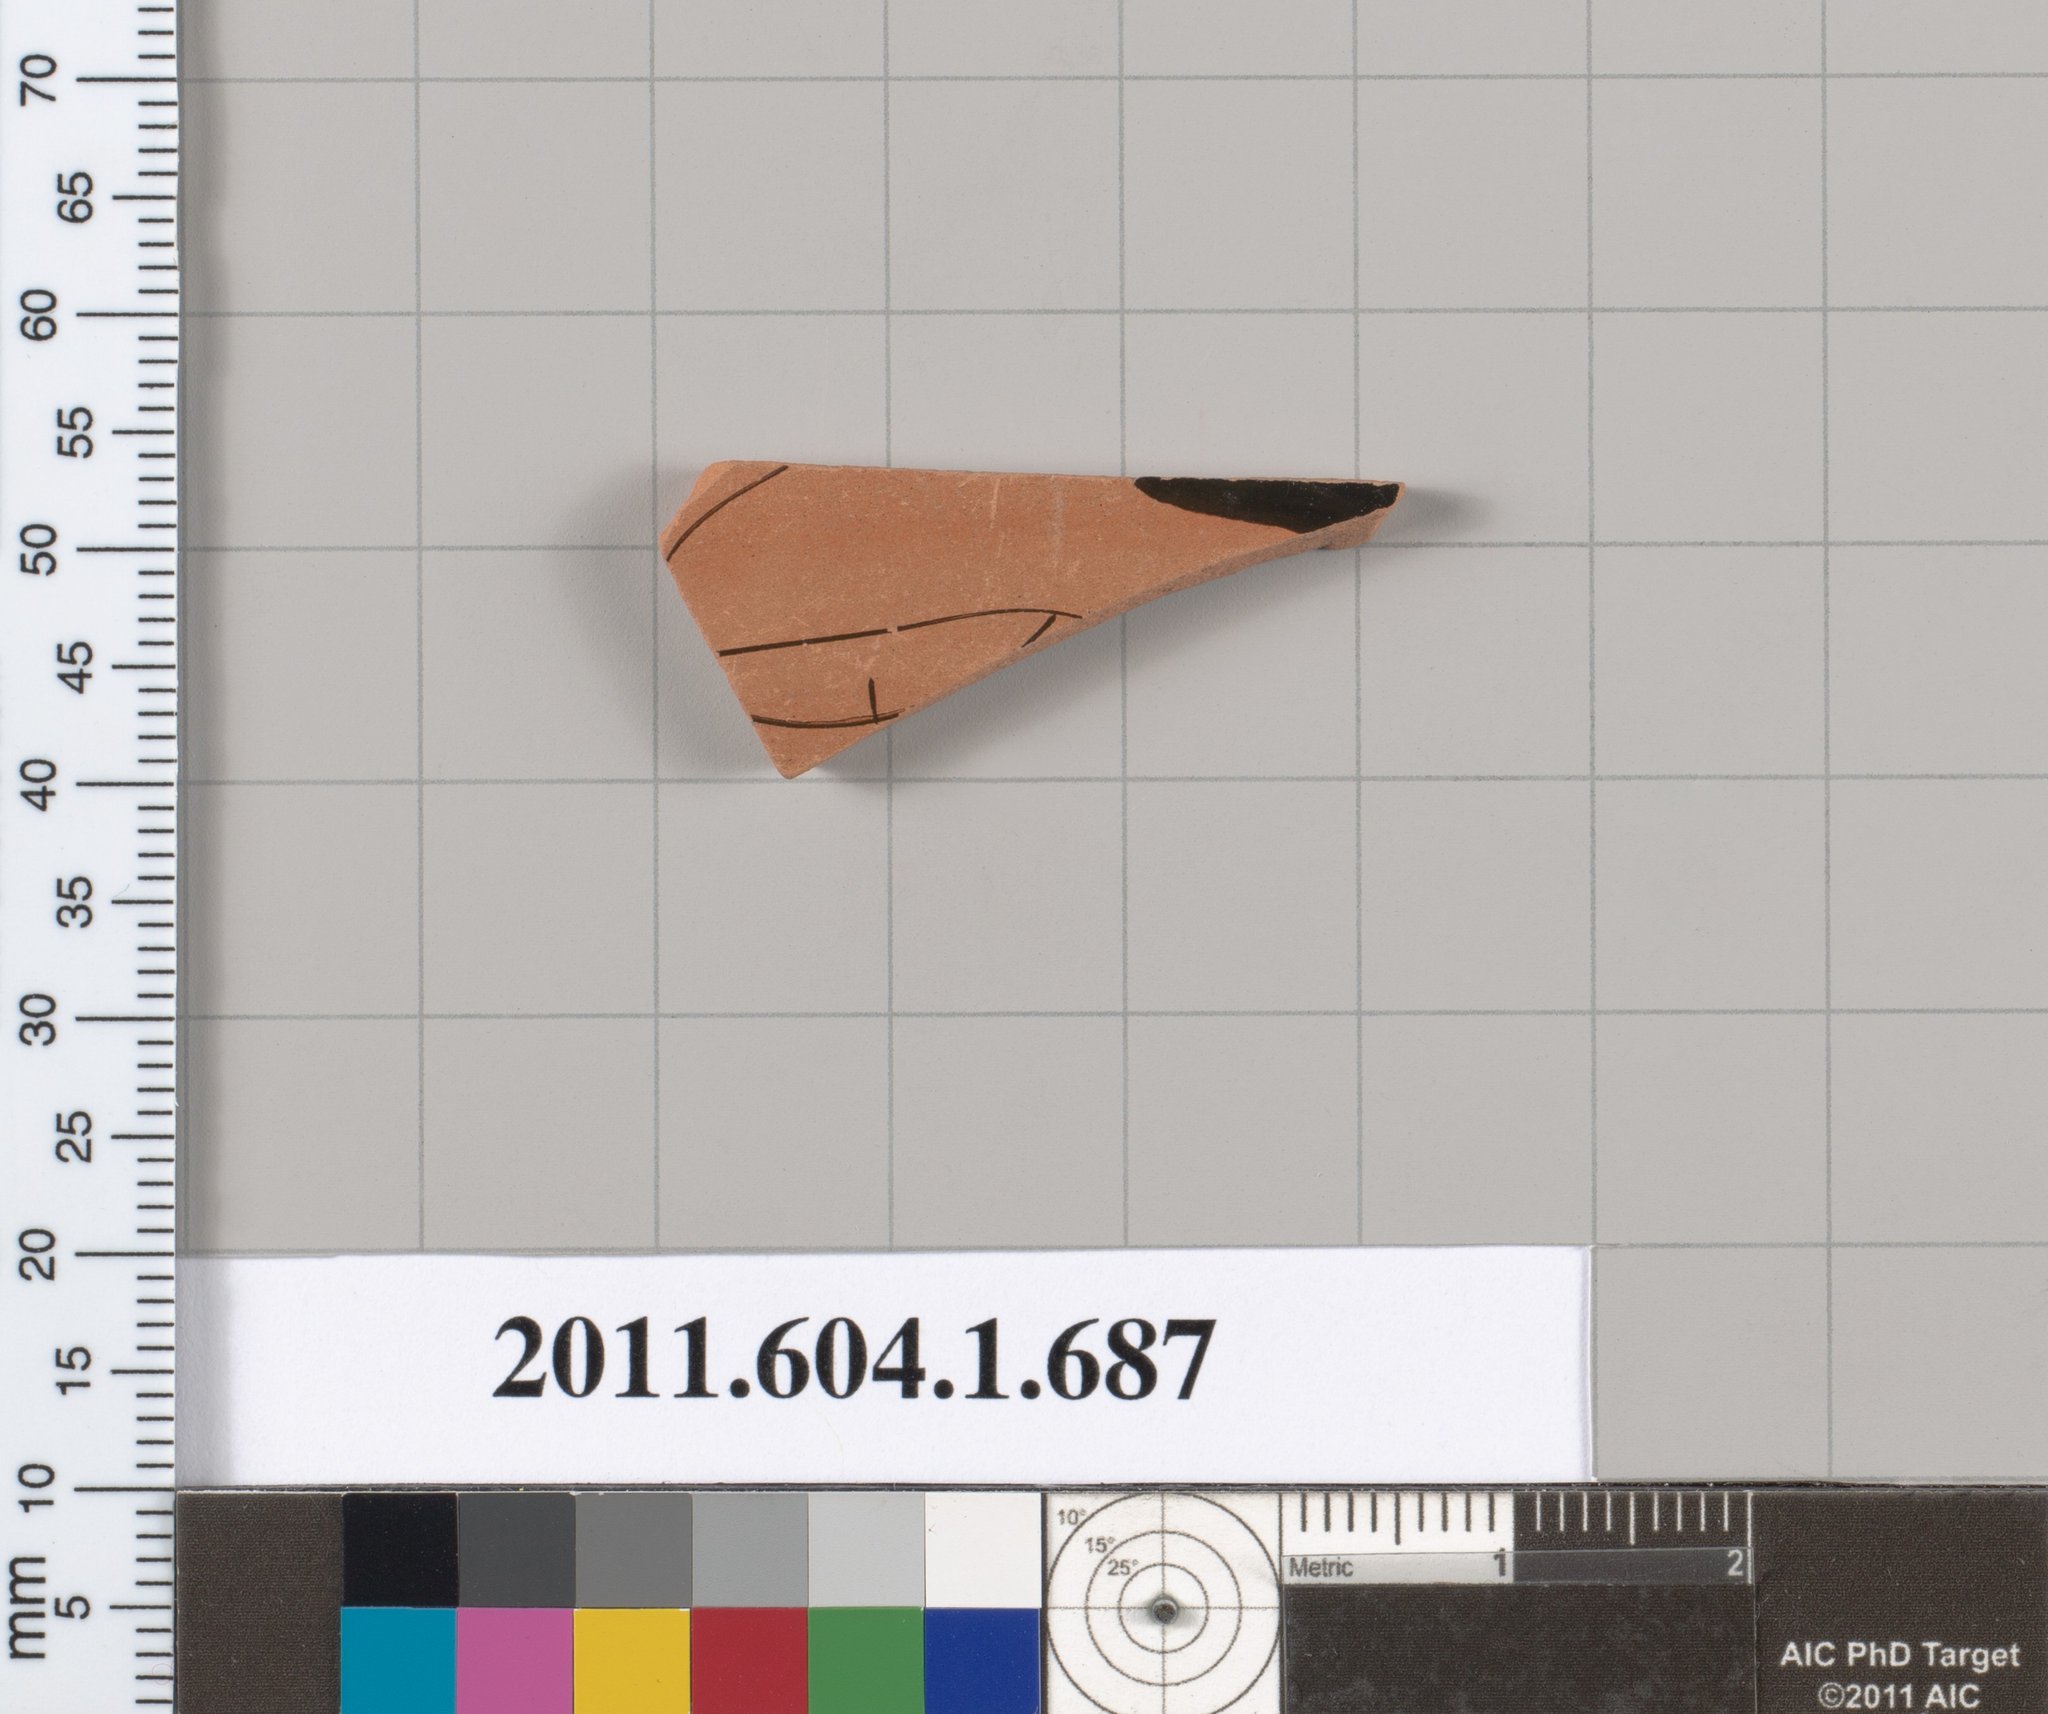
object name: kylix fragment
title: Terracotta fragment of a kylix (drinking cup)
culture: greek, attic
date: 475-451 BCE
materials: terracotta